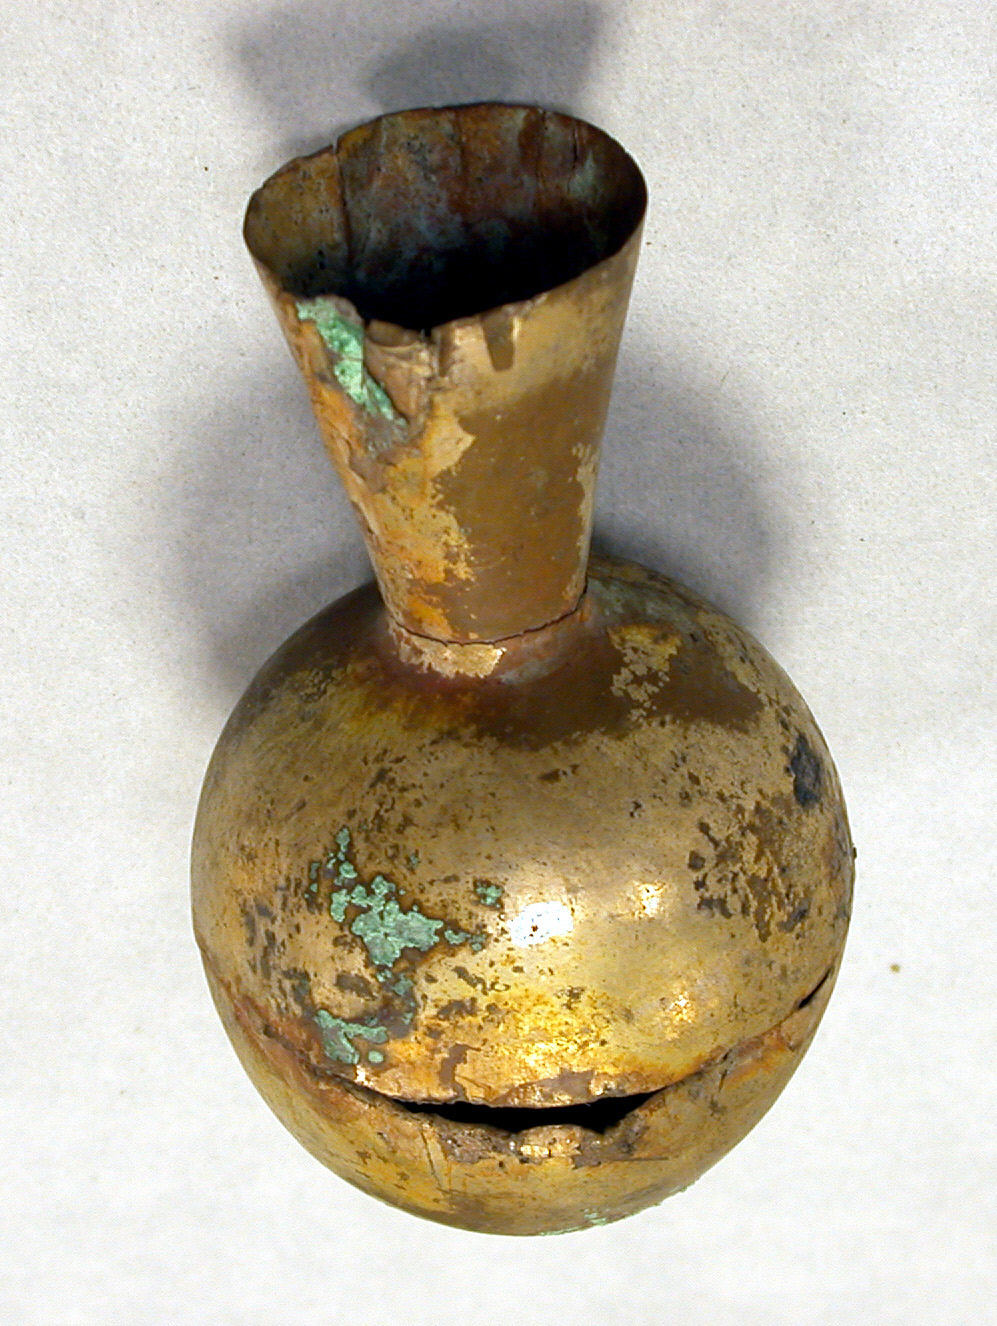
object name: bottle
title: Miniature Bottle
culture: chancay or chimú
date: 1001-1500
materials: gilt, silver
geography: peru